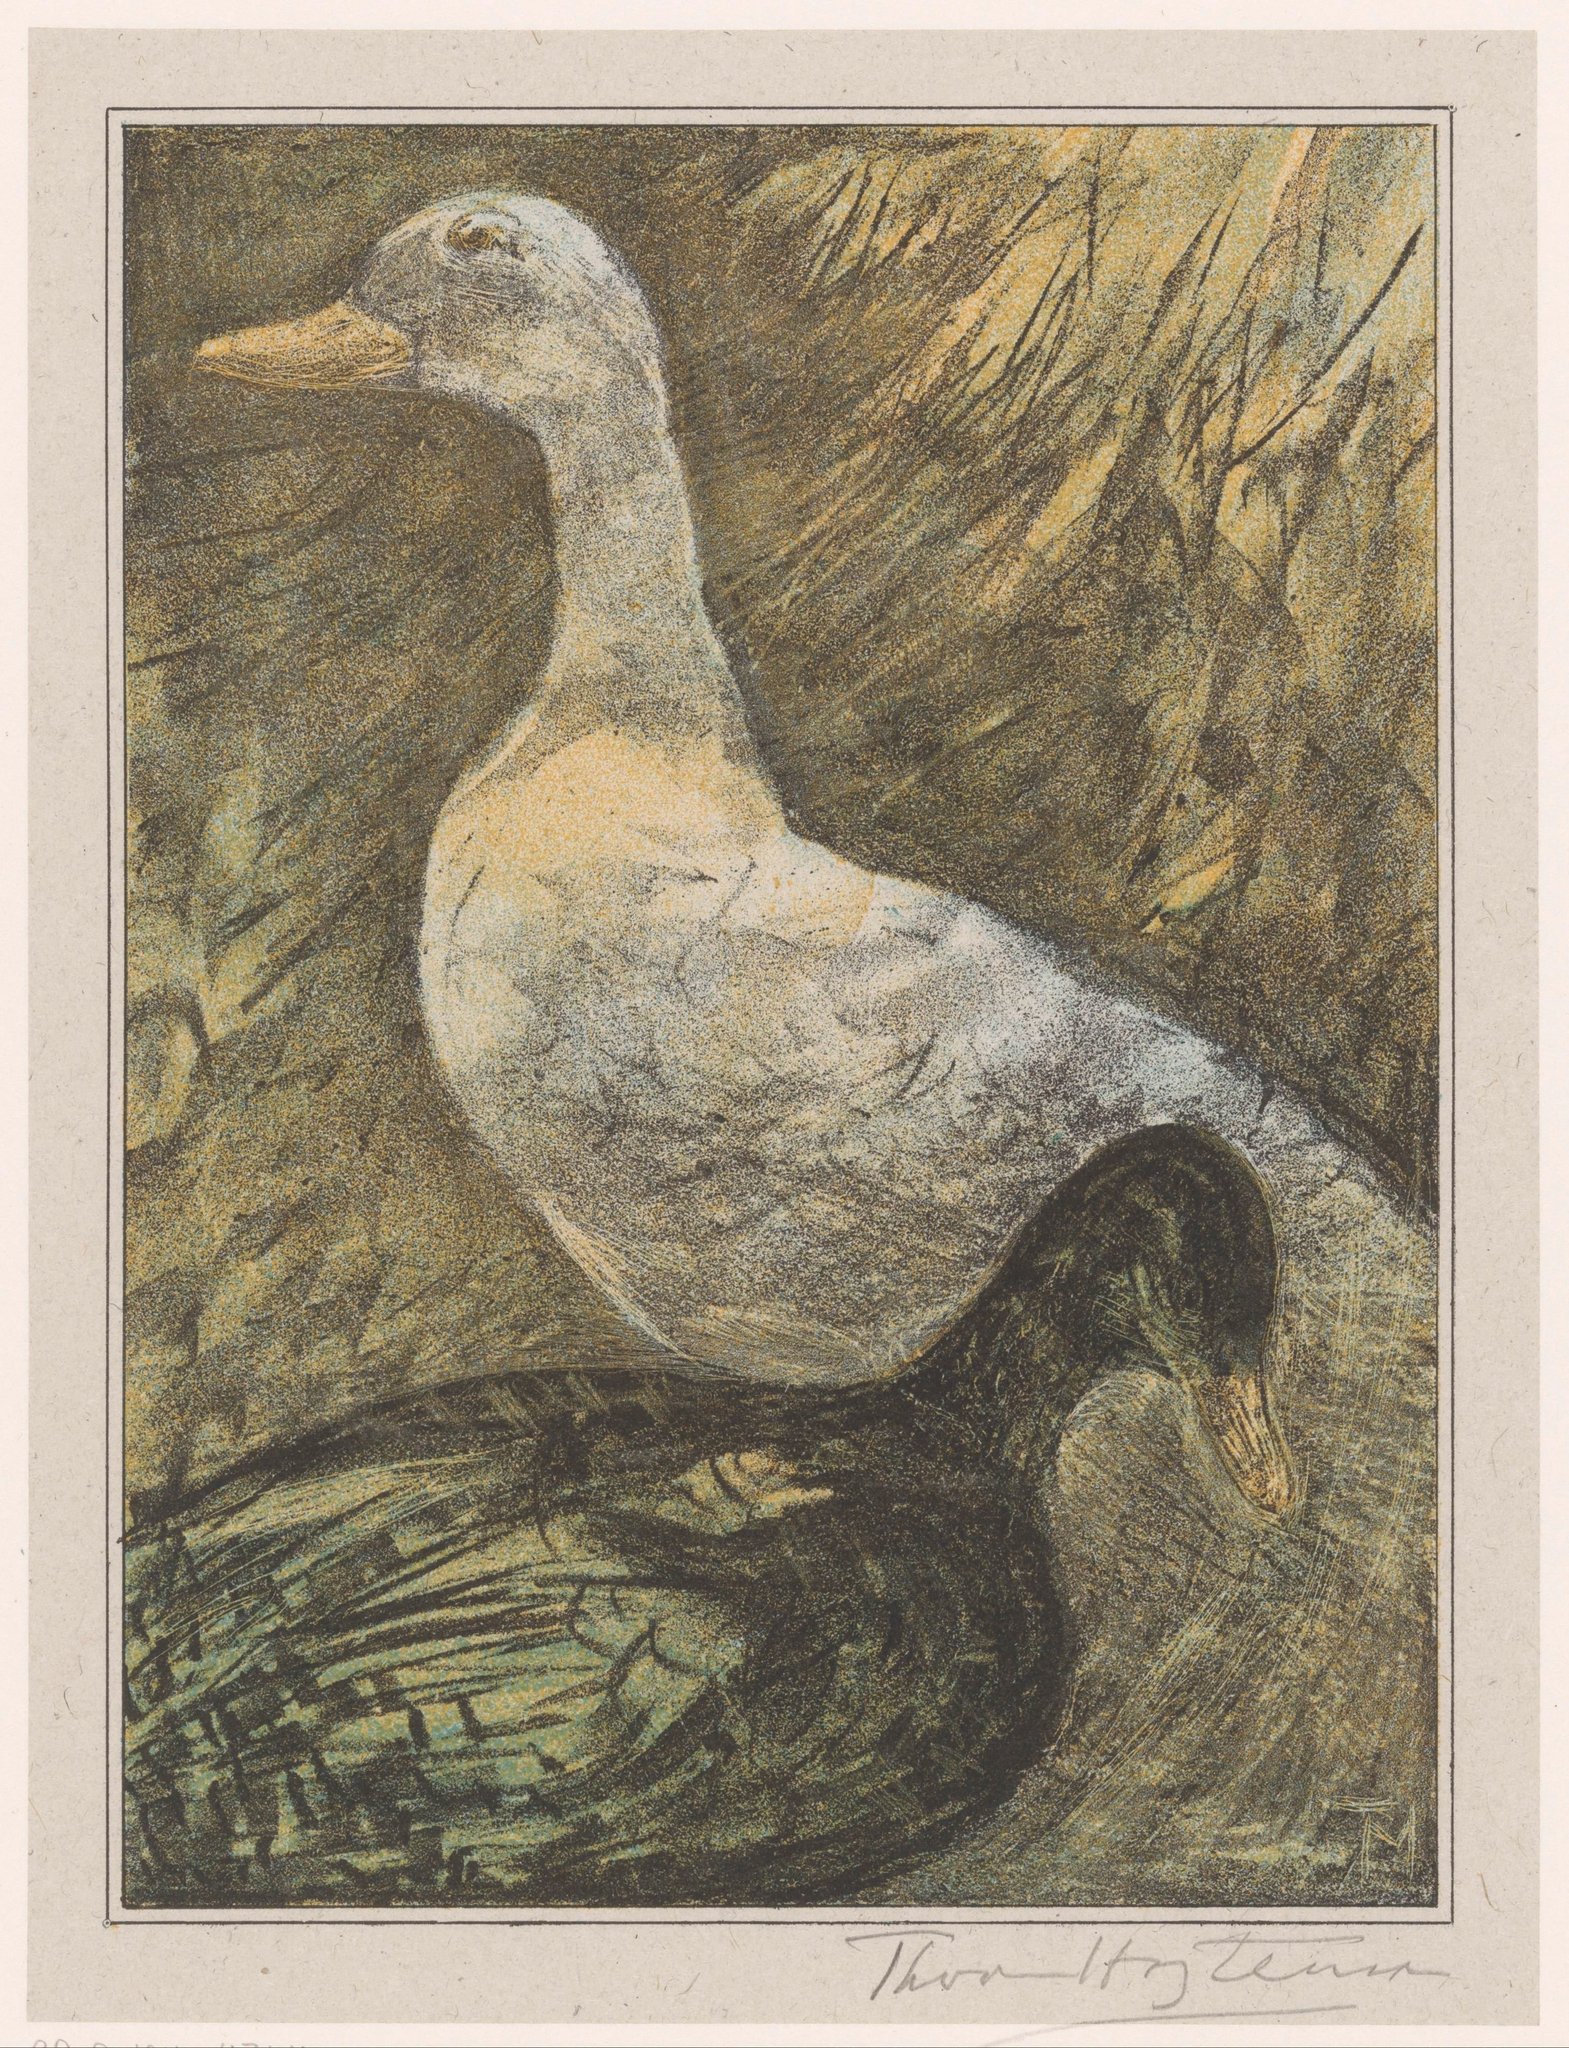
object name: print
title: Twee staande eenden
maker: theo van hoytema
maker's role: draughtsman, painter, print maker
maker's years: 1863-1917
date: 1878-1909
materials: paper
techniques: lithograph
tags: water-birds: duck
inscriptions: collector's mark: Lugt 2233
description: Prent is een proefdruk voor kalenderblad september 1909.